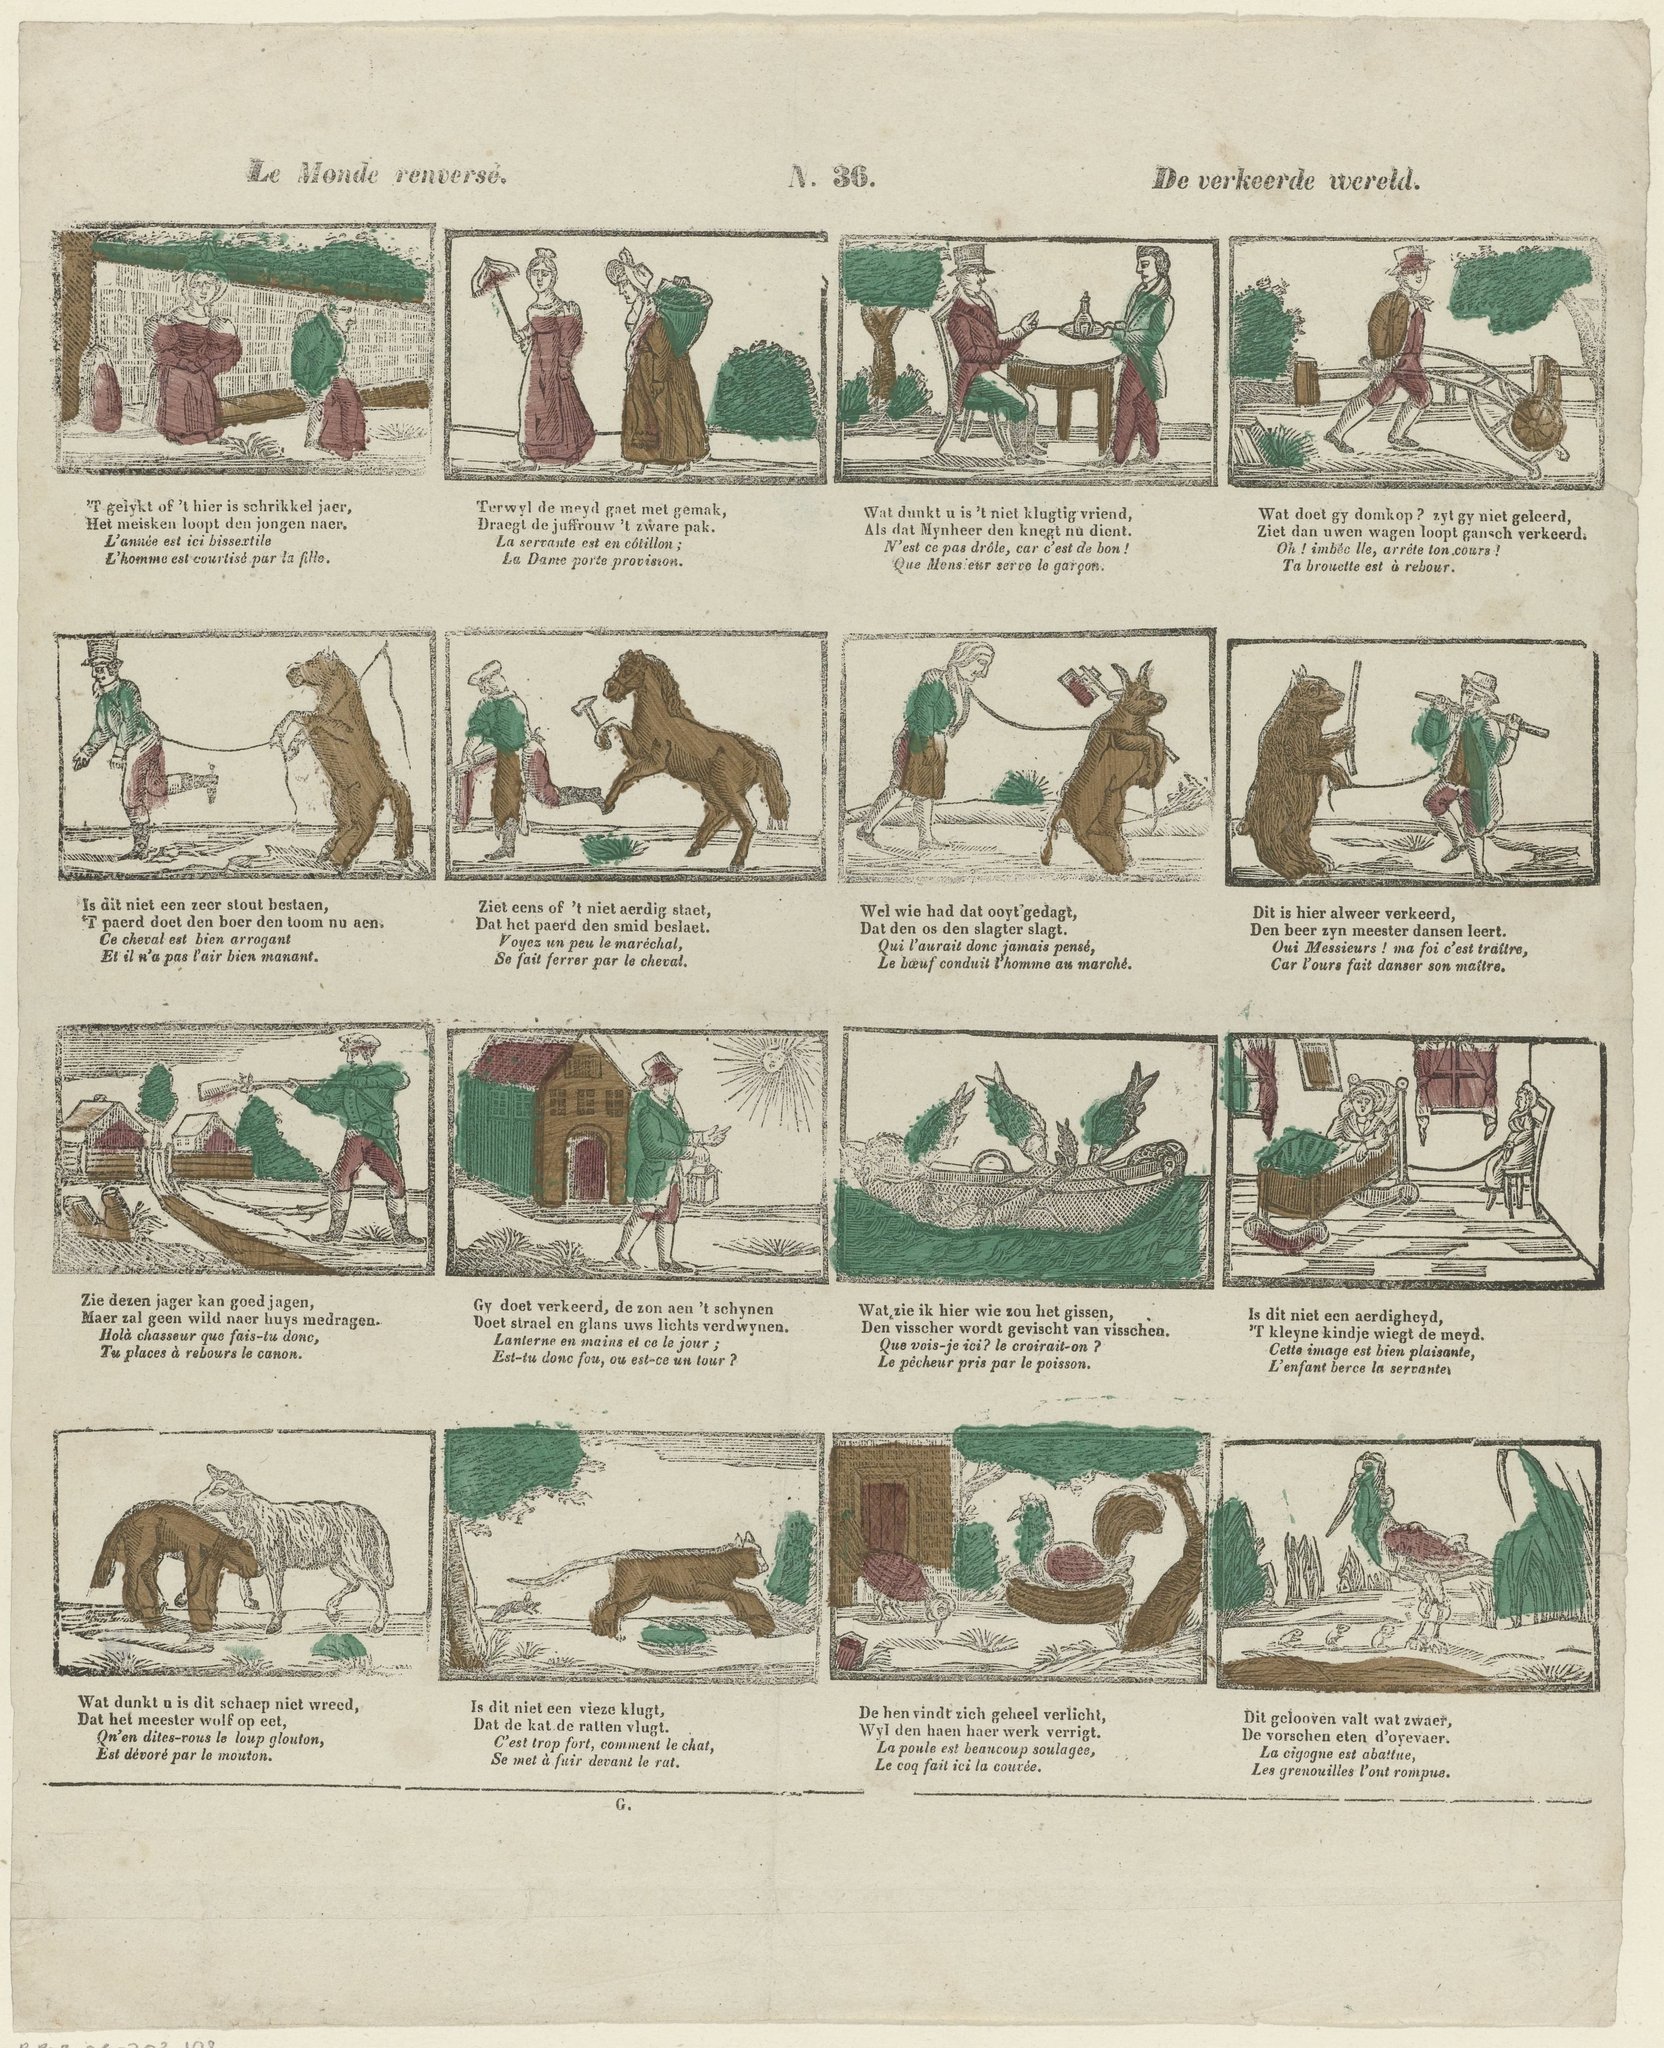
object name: print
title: Le monde renversé / De verkeerde wereld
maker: Anonymous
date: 1833-1856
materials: paper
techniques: colour, letterpress printing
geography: turnhout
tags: 'mundus inversus', the reversed world, the topsy-turvy world, 'le monde bestourné', animals acting as human beings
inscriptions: collector's mark: Lugt 2760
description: Blad met 16 voorstellingen over de verkeerde wereld, waar onder andere dieren zich als mensen gedragen. Onder elke voorstelling een tweeregelig vers in het Nederlands en in het Frans. Genummerd midden boven: N. 36.